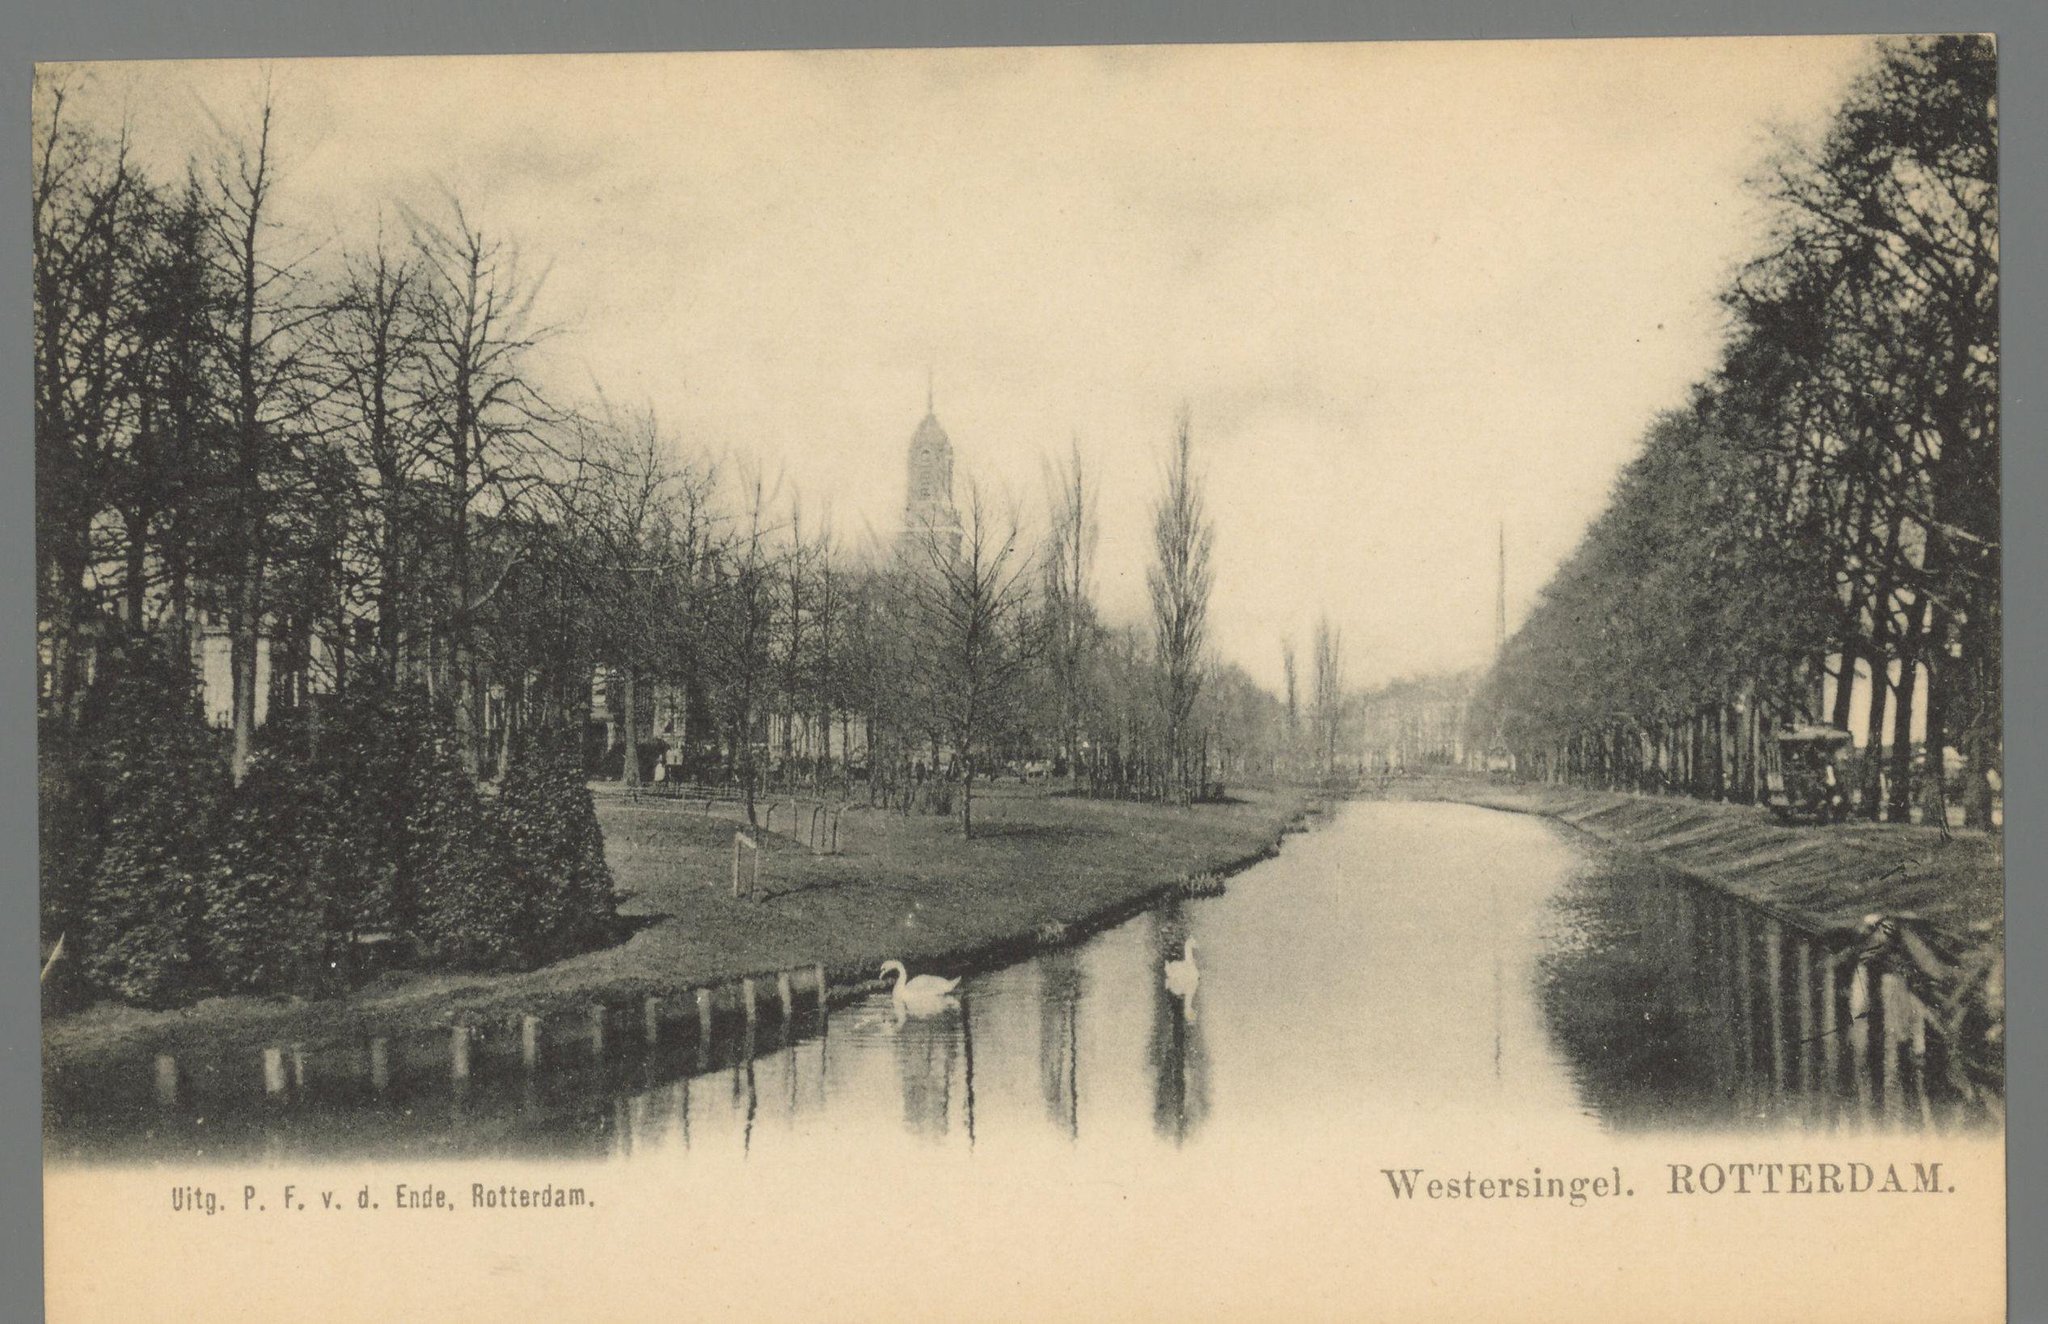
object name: photomechanical print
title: Westersingel. Rotterdam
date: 1897-1905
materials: cardboard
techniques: photograph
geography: rotterdam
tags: park, canals, waters (in city), street, rotterdam